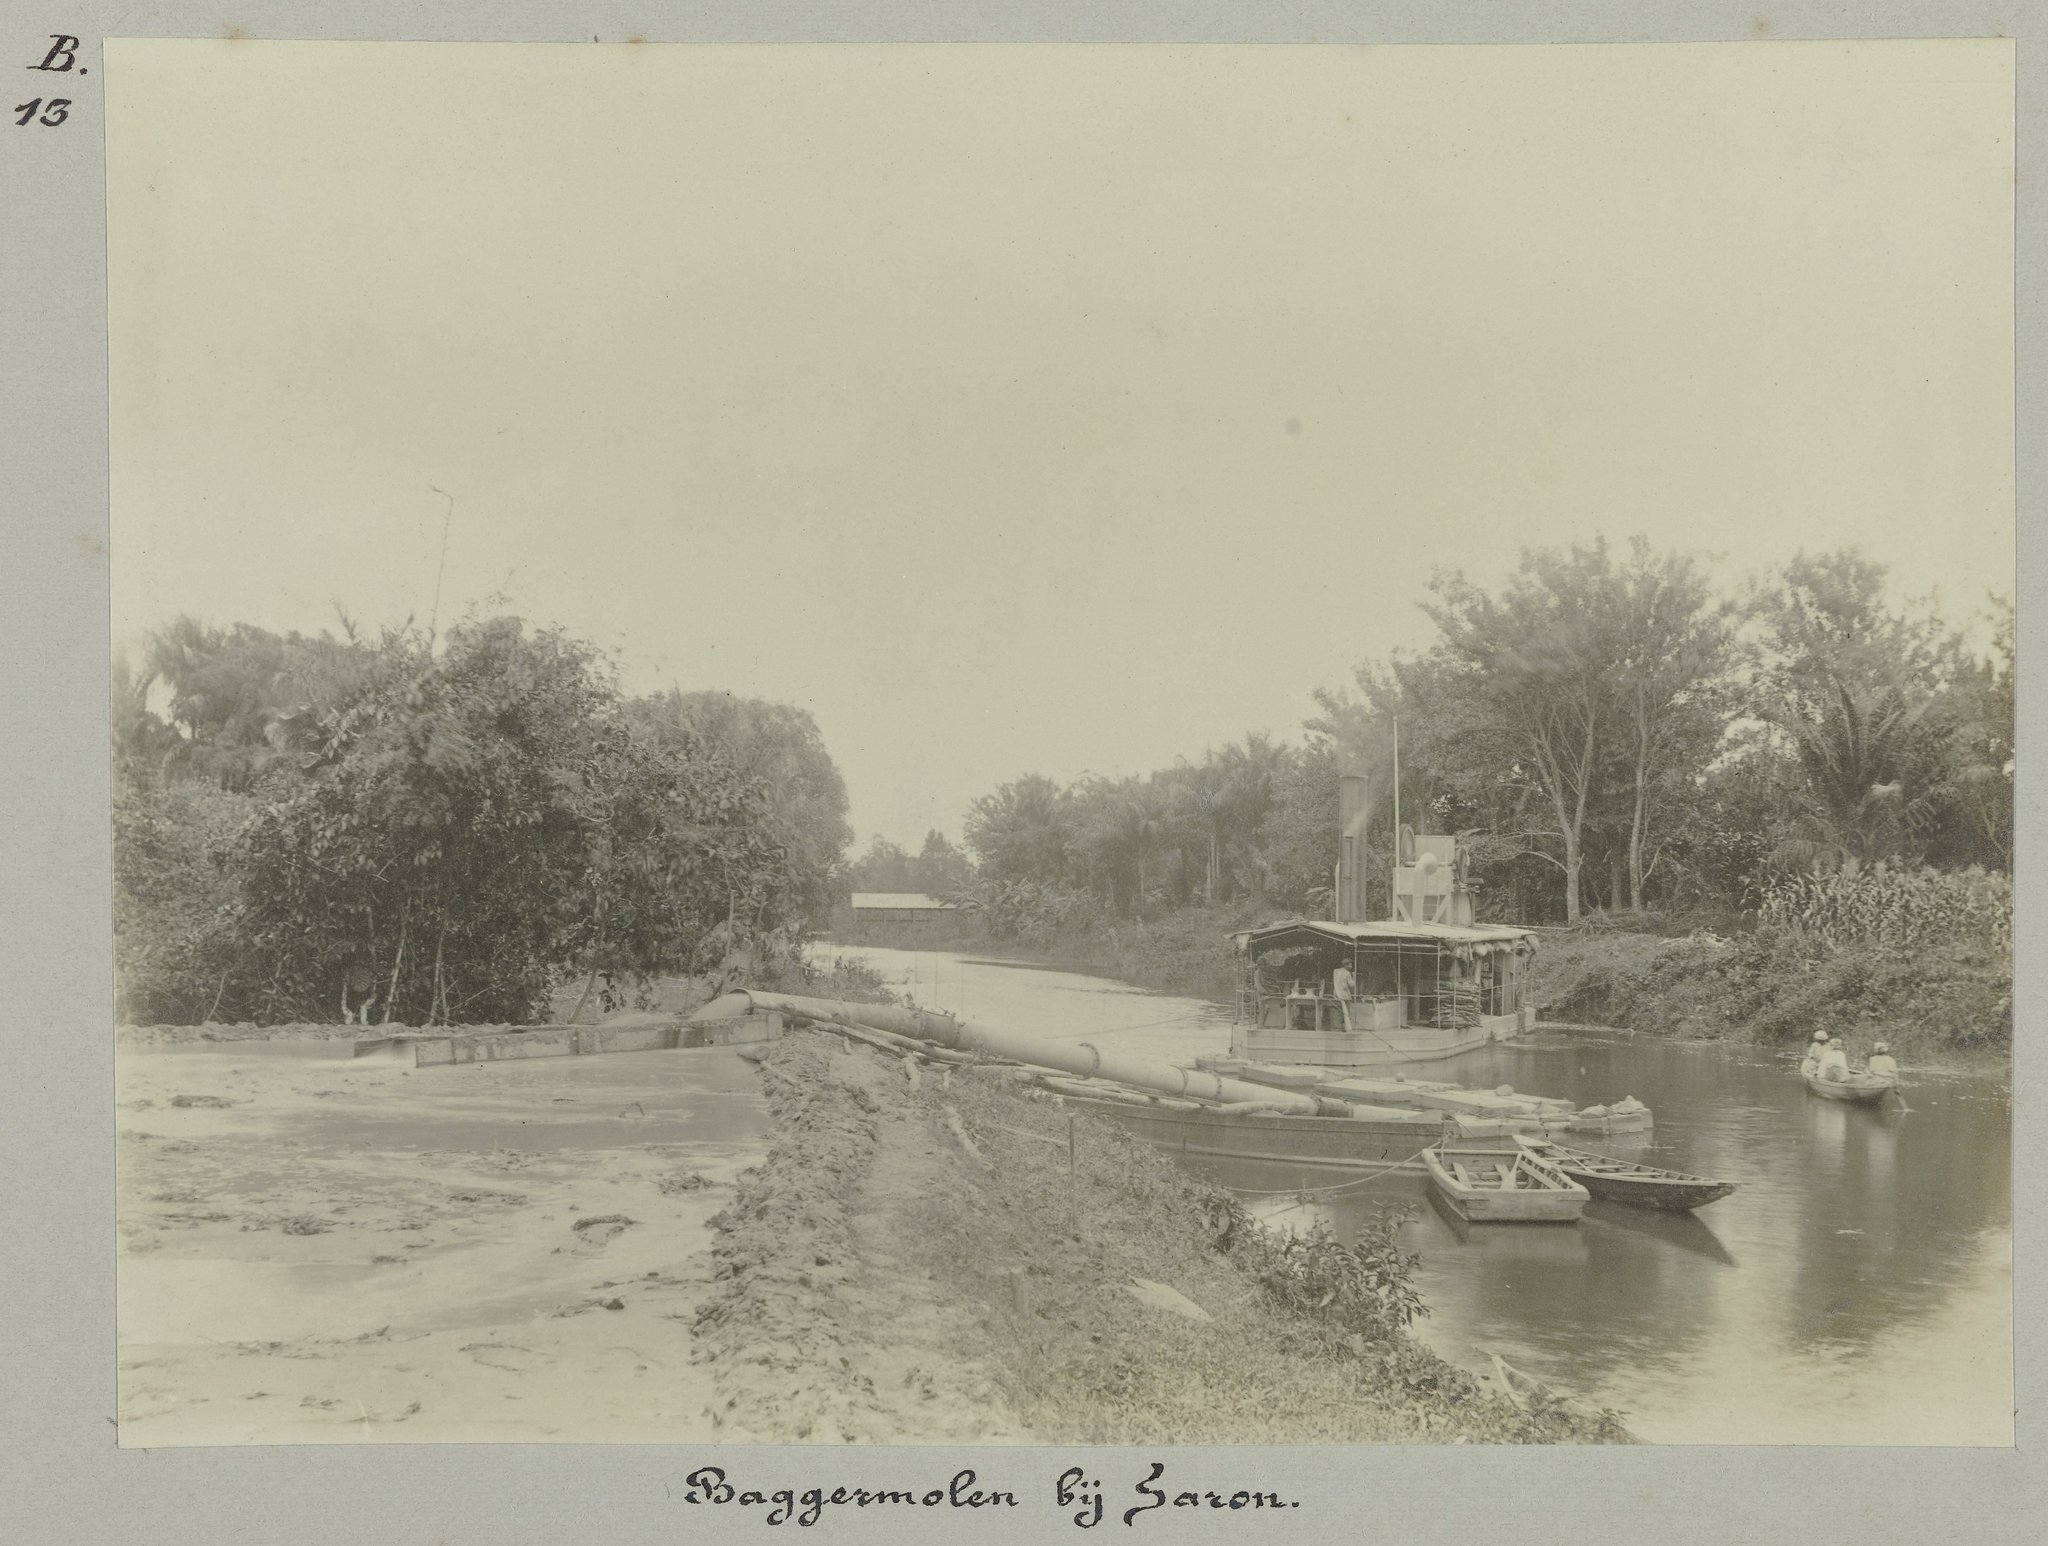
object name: photograph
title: Baggermolen bij Saron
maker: hendrik doijer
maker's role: engineer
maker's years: 1863-1925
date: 1903-1910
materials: photographic support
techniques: gelatin silver print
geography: suriname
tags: suriname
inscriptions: inscription: ‘B.13 / Baggermolen bij Saron.’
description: Een baggermolen aan het werk in een kanaal bij Saron. Onderdeel van het fotoalbum Souvenir de Voyage (deel 2), over het leven van de familie Doijer in en rond de plantage Ma Retraite in Suriname in de jaren 1903-1910.